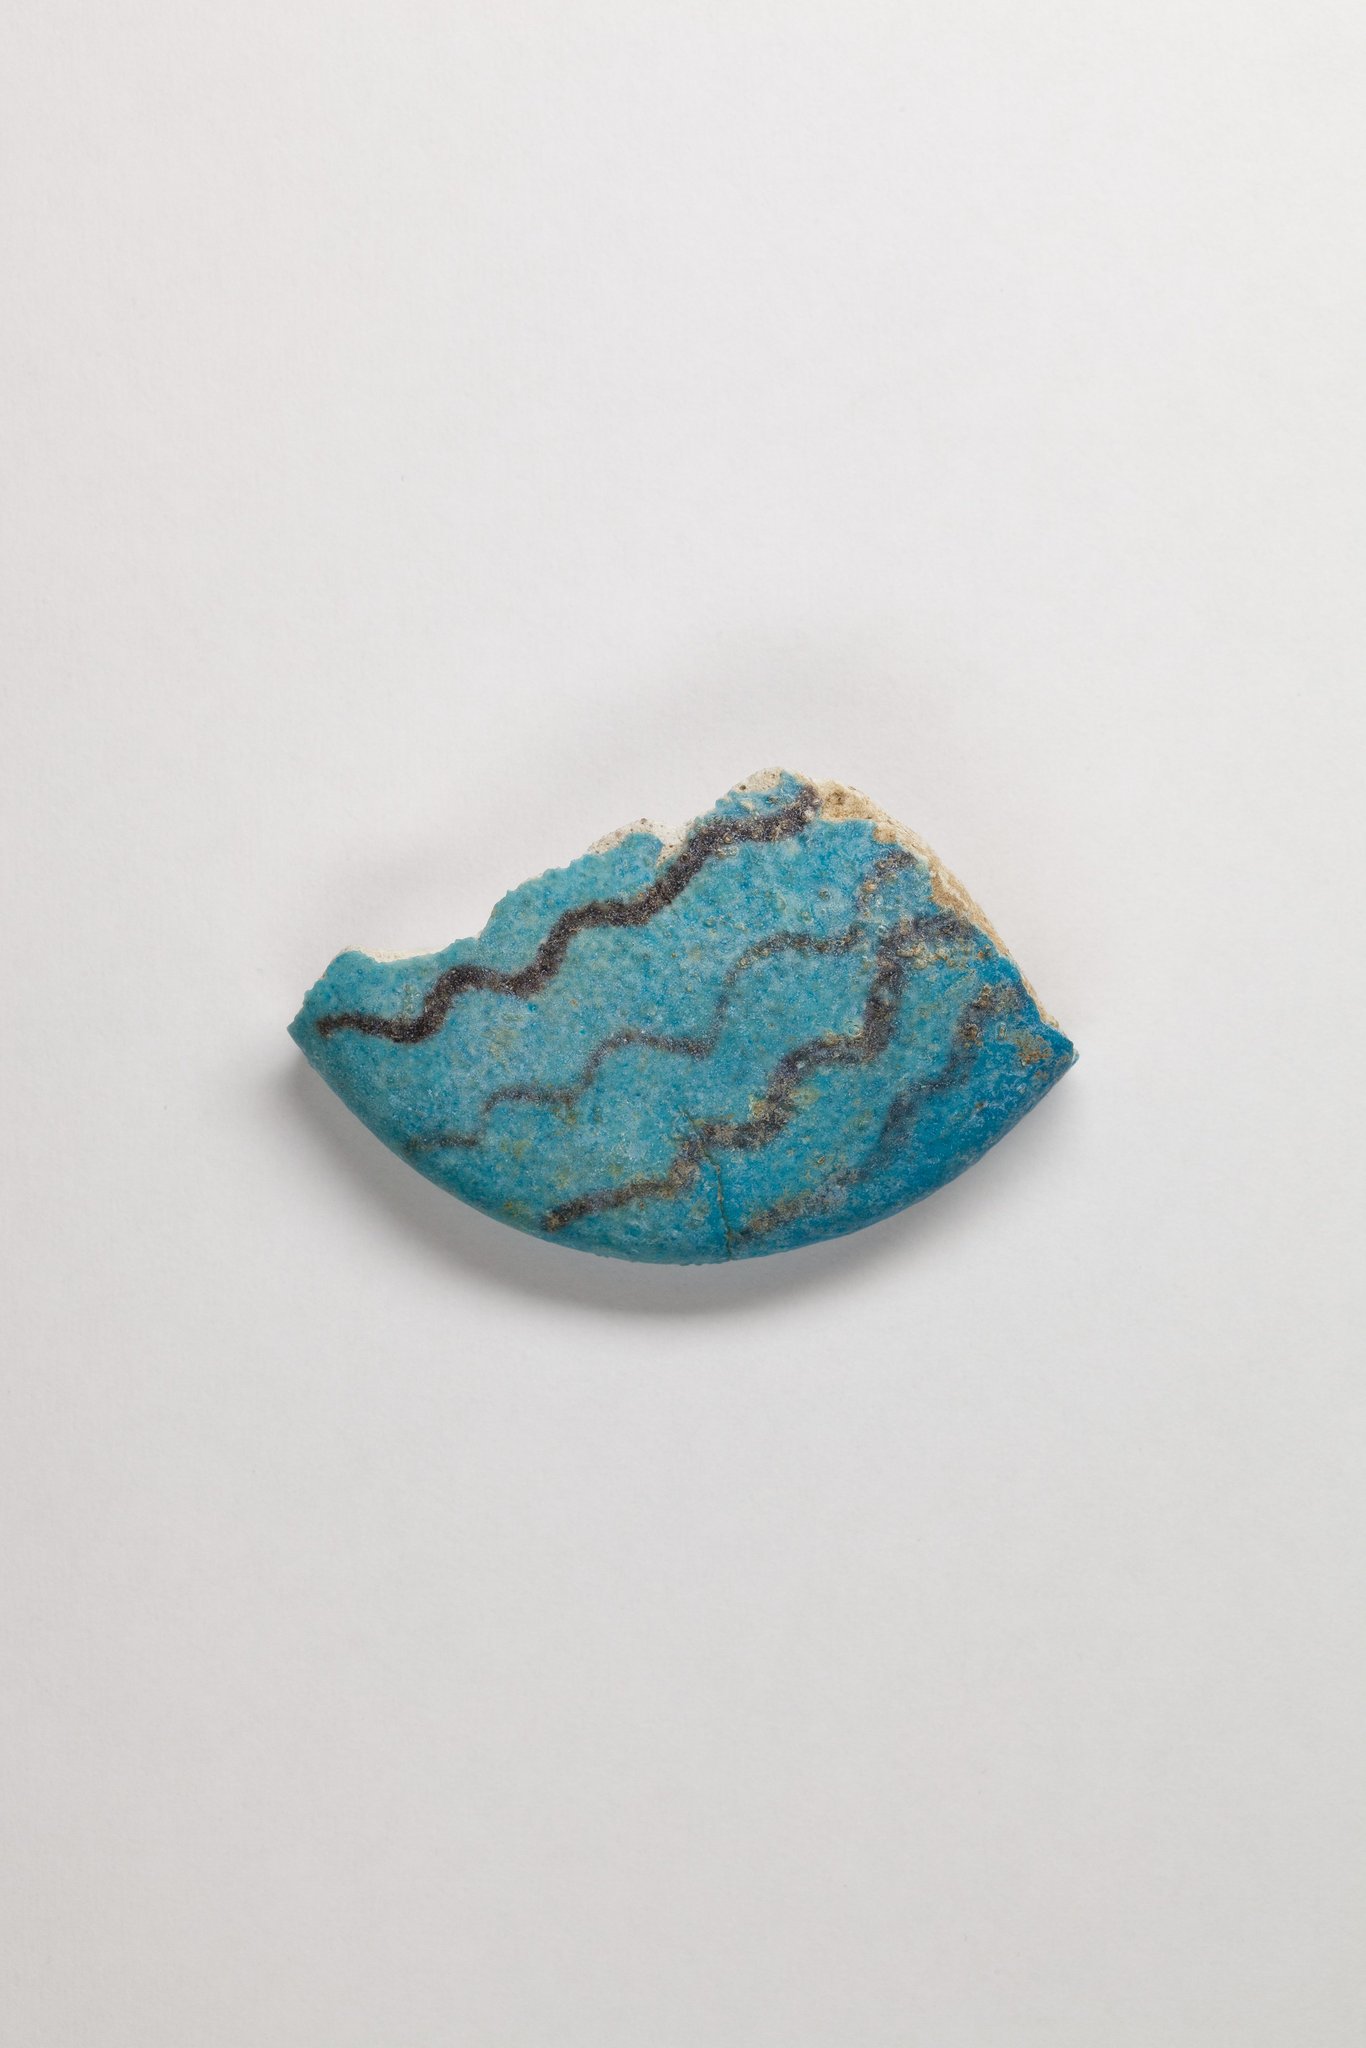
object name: vase fragment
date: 1981-1640 BCE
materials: faience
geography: egypt